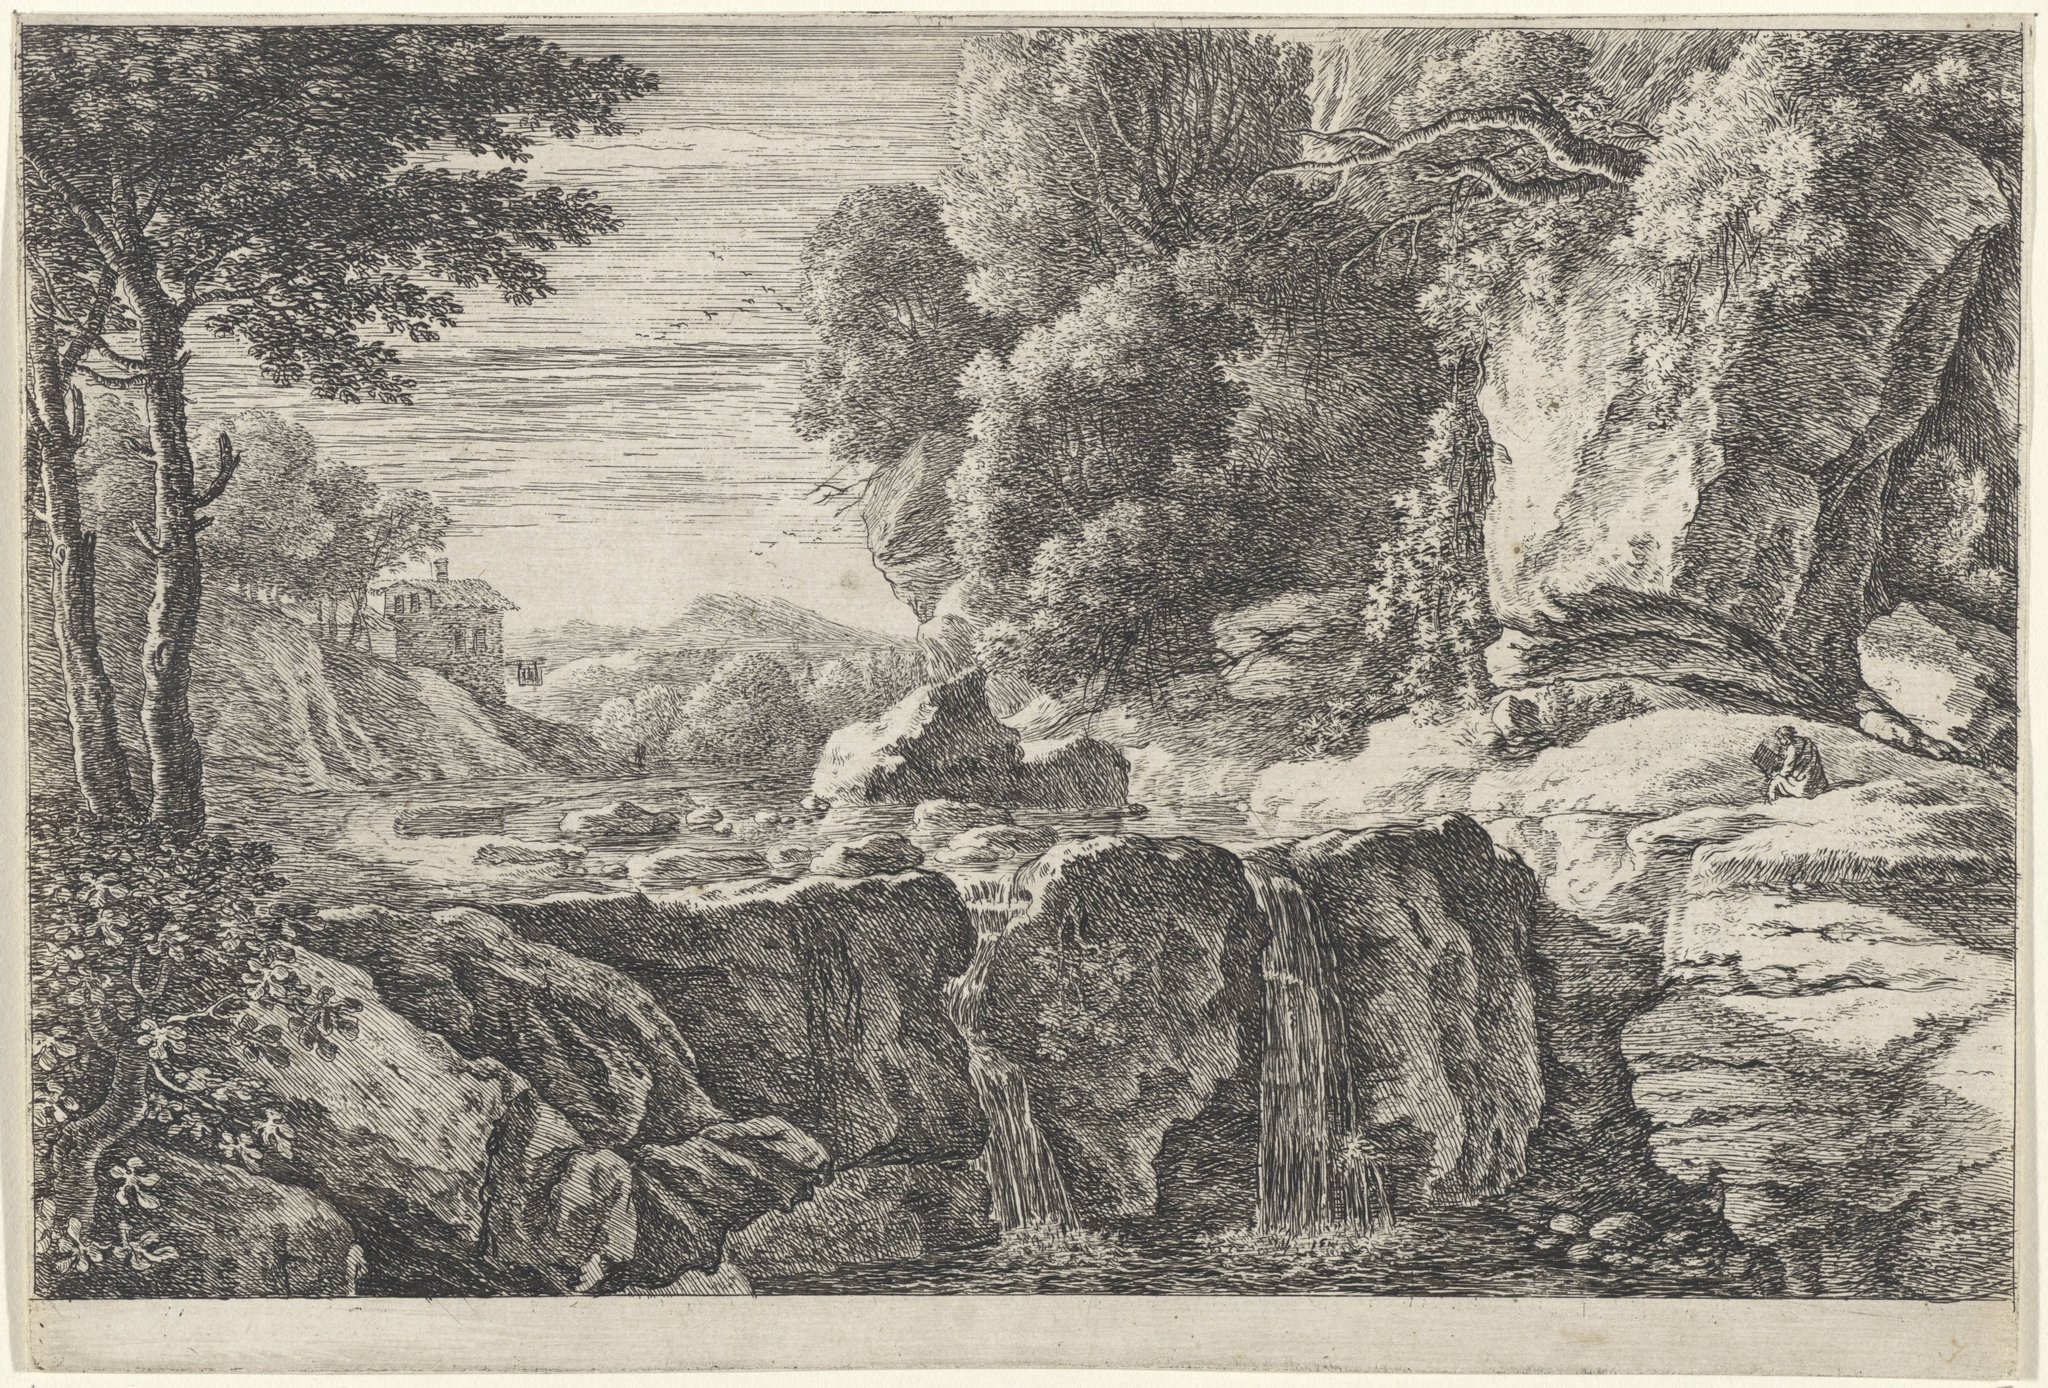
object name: print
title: Vier rivierlandschappen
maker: herman van swanevelt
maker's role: draughtsman, painter, print maker, publisher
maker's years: 1603-1655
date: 1643-1655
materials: paper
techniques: etching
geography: paris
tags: river, waterfall, rural housing, e.g. country-house, villa, cottage, (high) hill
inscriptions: collector's mark: Lugt 2228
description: Een lezende of schrijvende figuur zit bij een kleine waterval. In de verte staat een gebouw aan de voet van een heuvel.